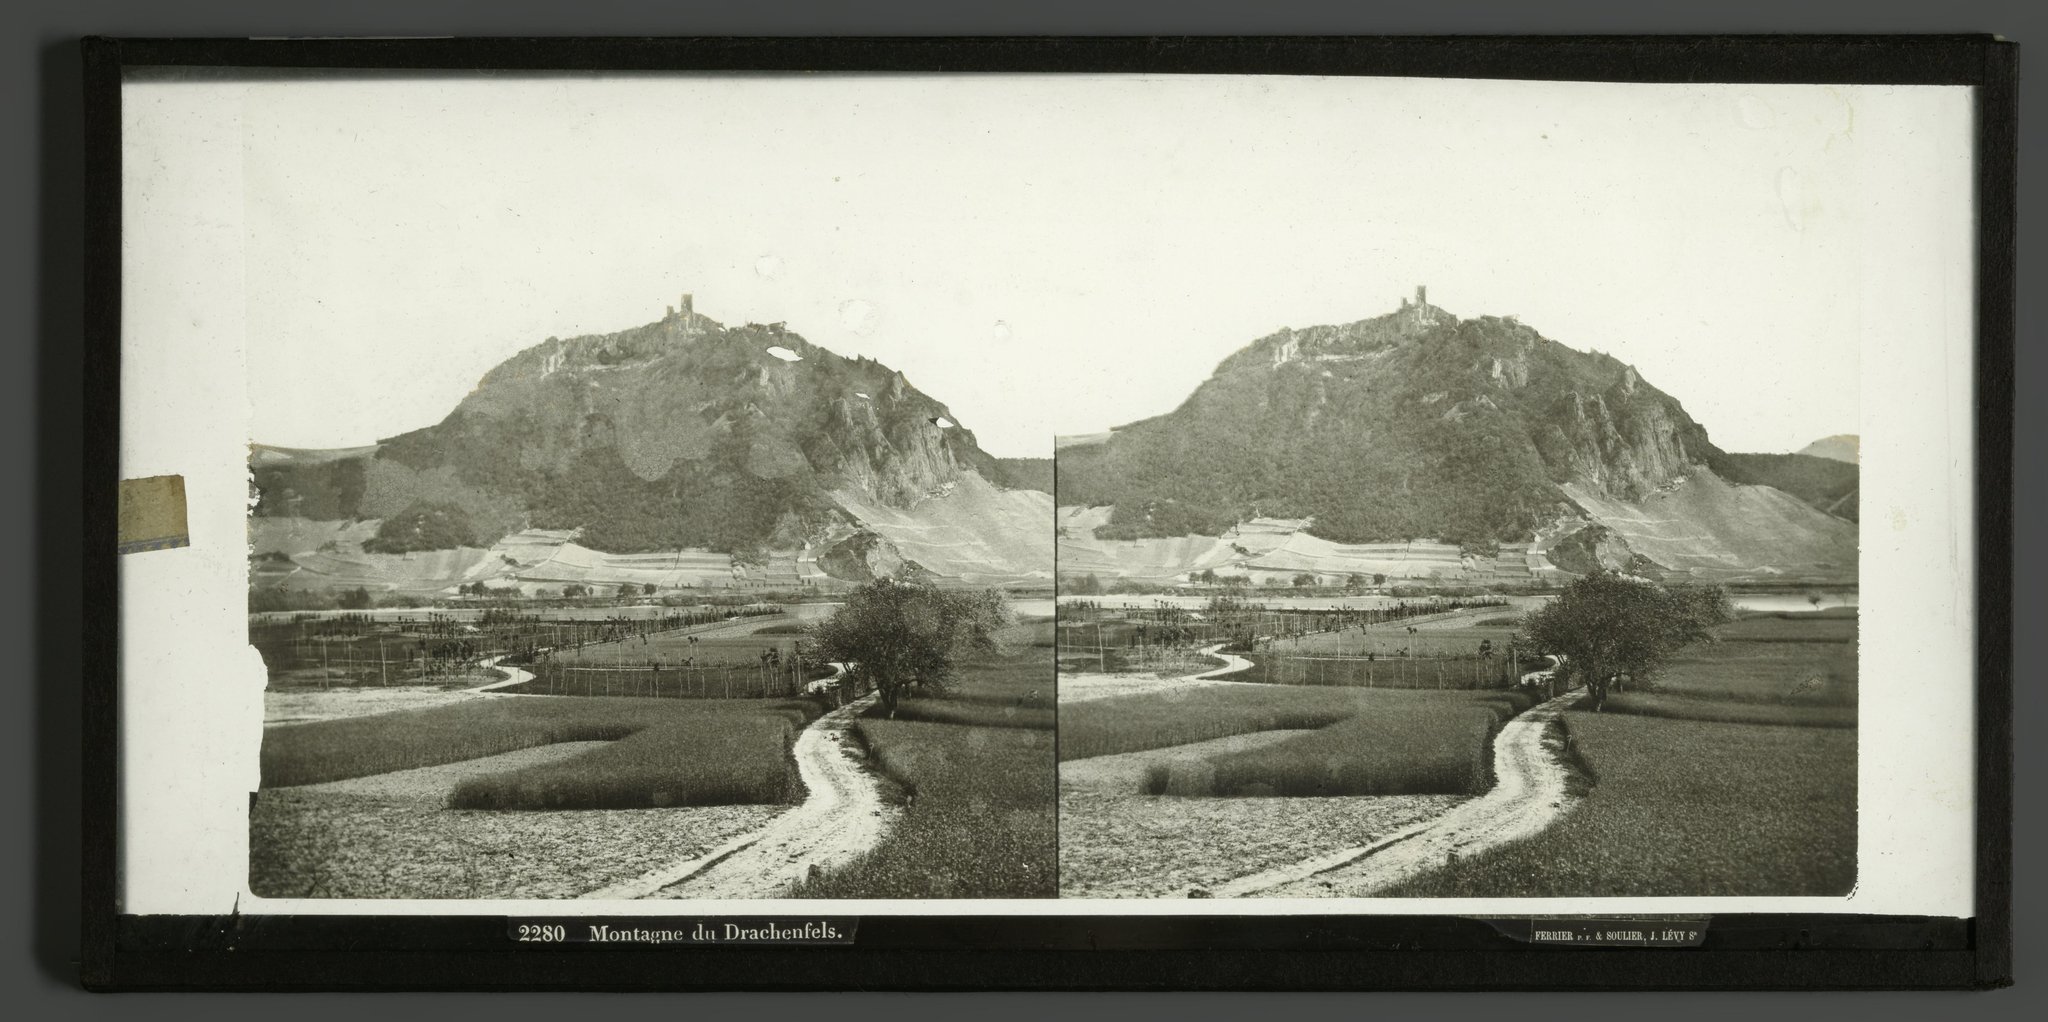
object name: photograph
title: Gezicht op de Drachenfels in Duitsland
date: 1864-1873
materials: glass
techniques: slide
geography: germany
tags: mountains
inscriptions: number: ‘2280’